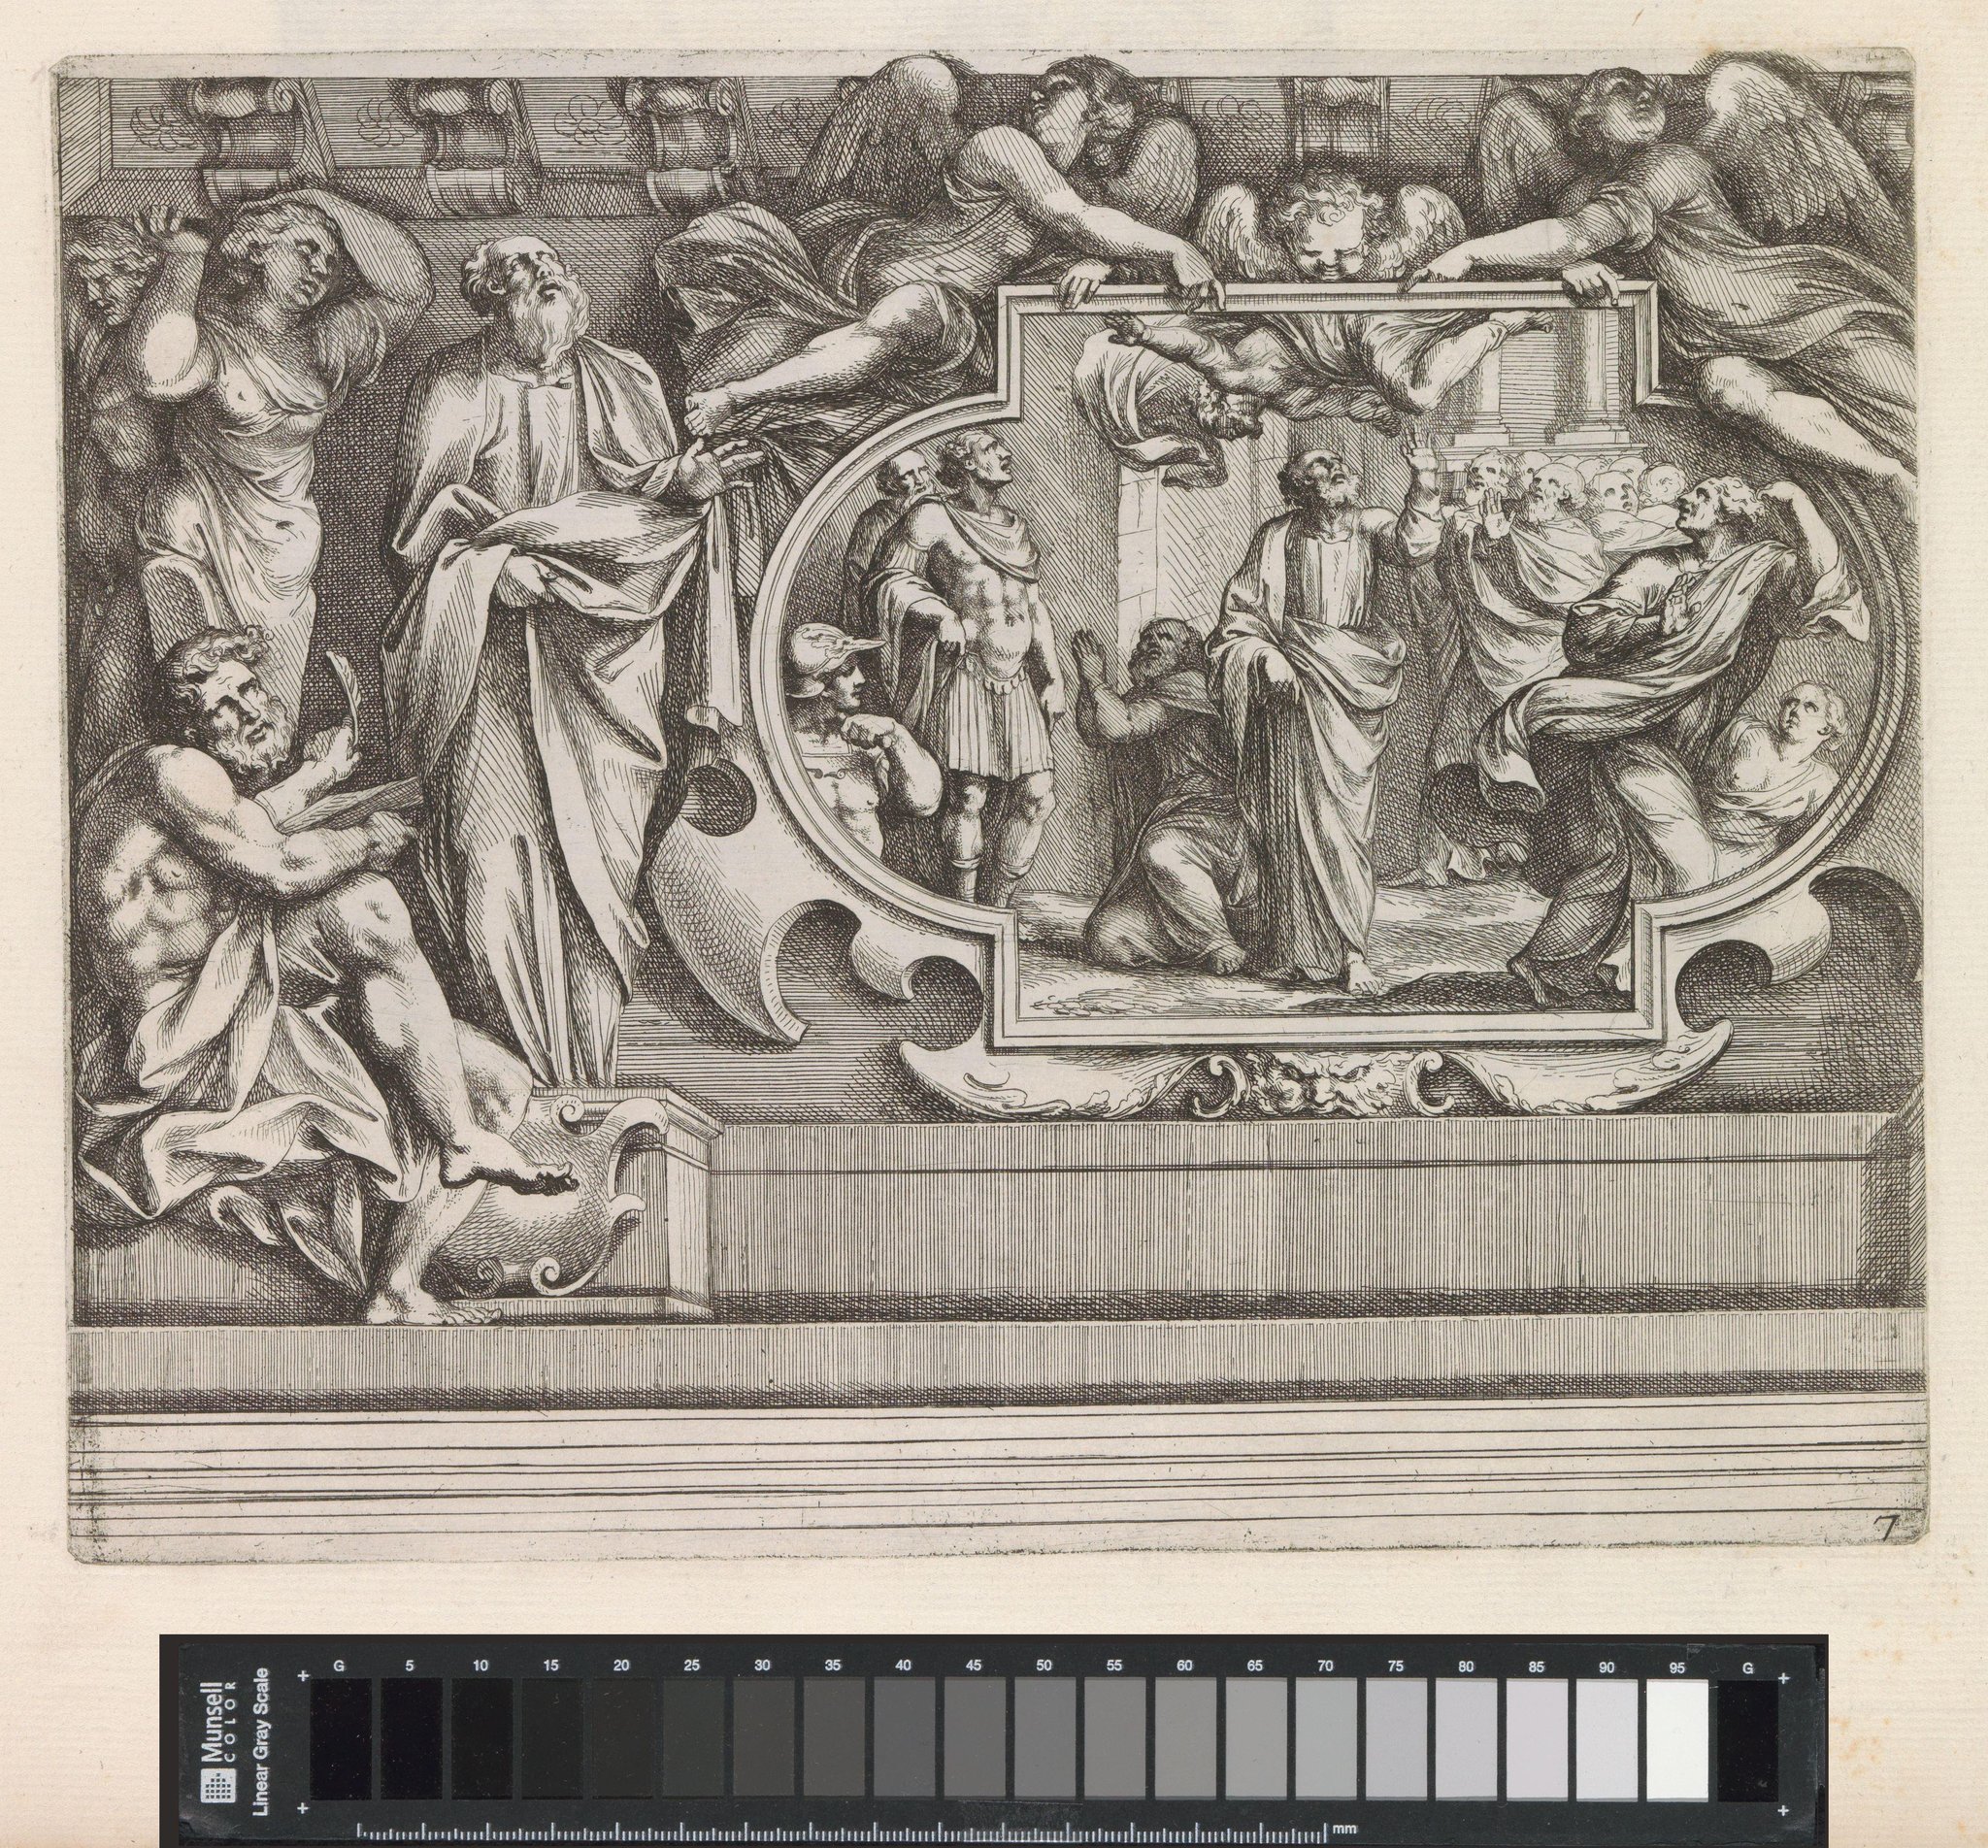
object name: album leaf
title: Schilderingen van Giovanni Lanfranco bedoeld voor de Loggia del Benedizione in het Vaticaan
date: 1665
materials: paper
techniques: etching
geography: italy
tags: life and acts of peter, life and acts of paul (saul), the apostle peter, first bishop of rome; possible attributes: book, cock, (upturned) cross, (triple) crozier, fish, key, scroll, ship, tiara, the apostle paul of tarsus; possible attributes: book, scroll, sword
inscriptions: number: ‘84’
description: Deze prent maakt deel uit van een reeks van vermoedelijk 21 prenten (in het Rijksmuseum bevinden zich 18 prenten) naar de ontwerpen van Giovanni Lanfranco voor schilderingen in de Loggia del Benedizione in het Vaticaan over de geschiedenis van Petrus en Paulus.